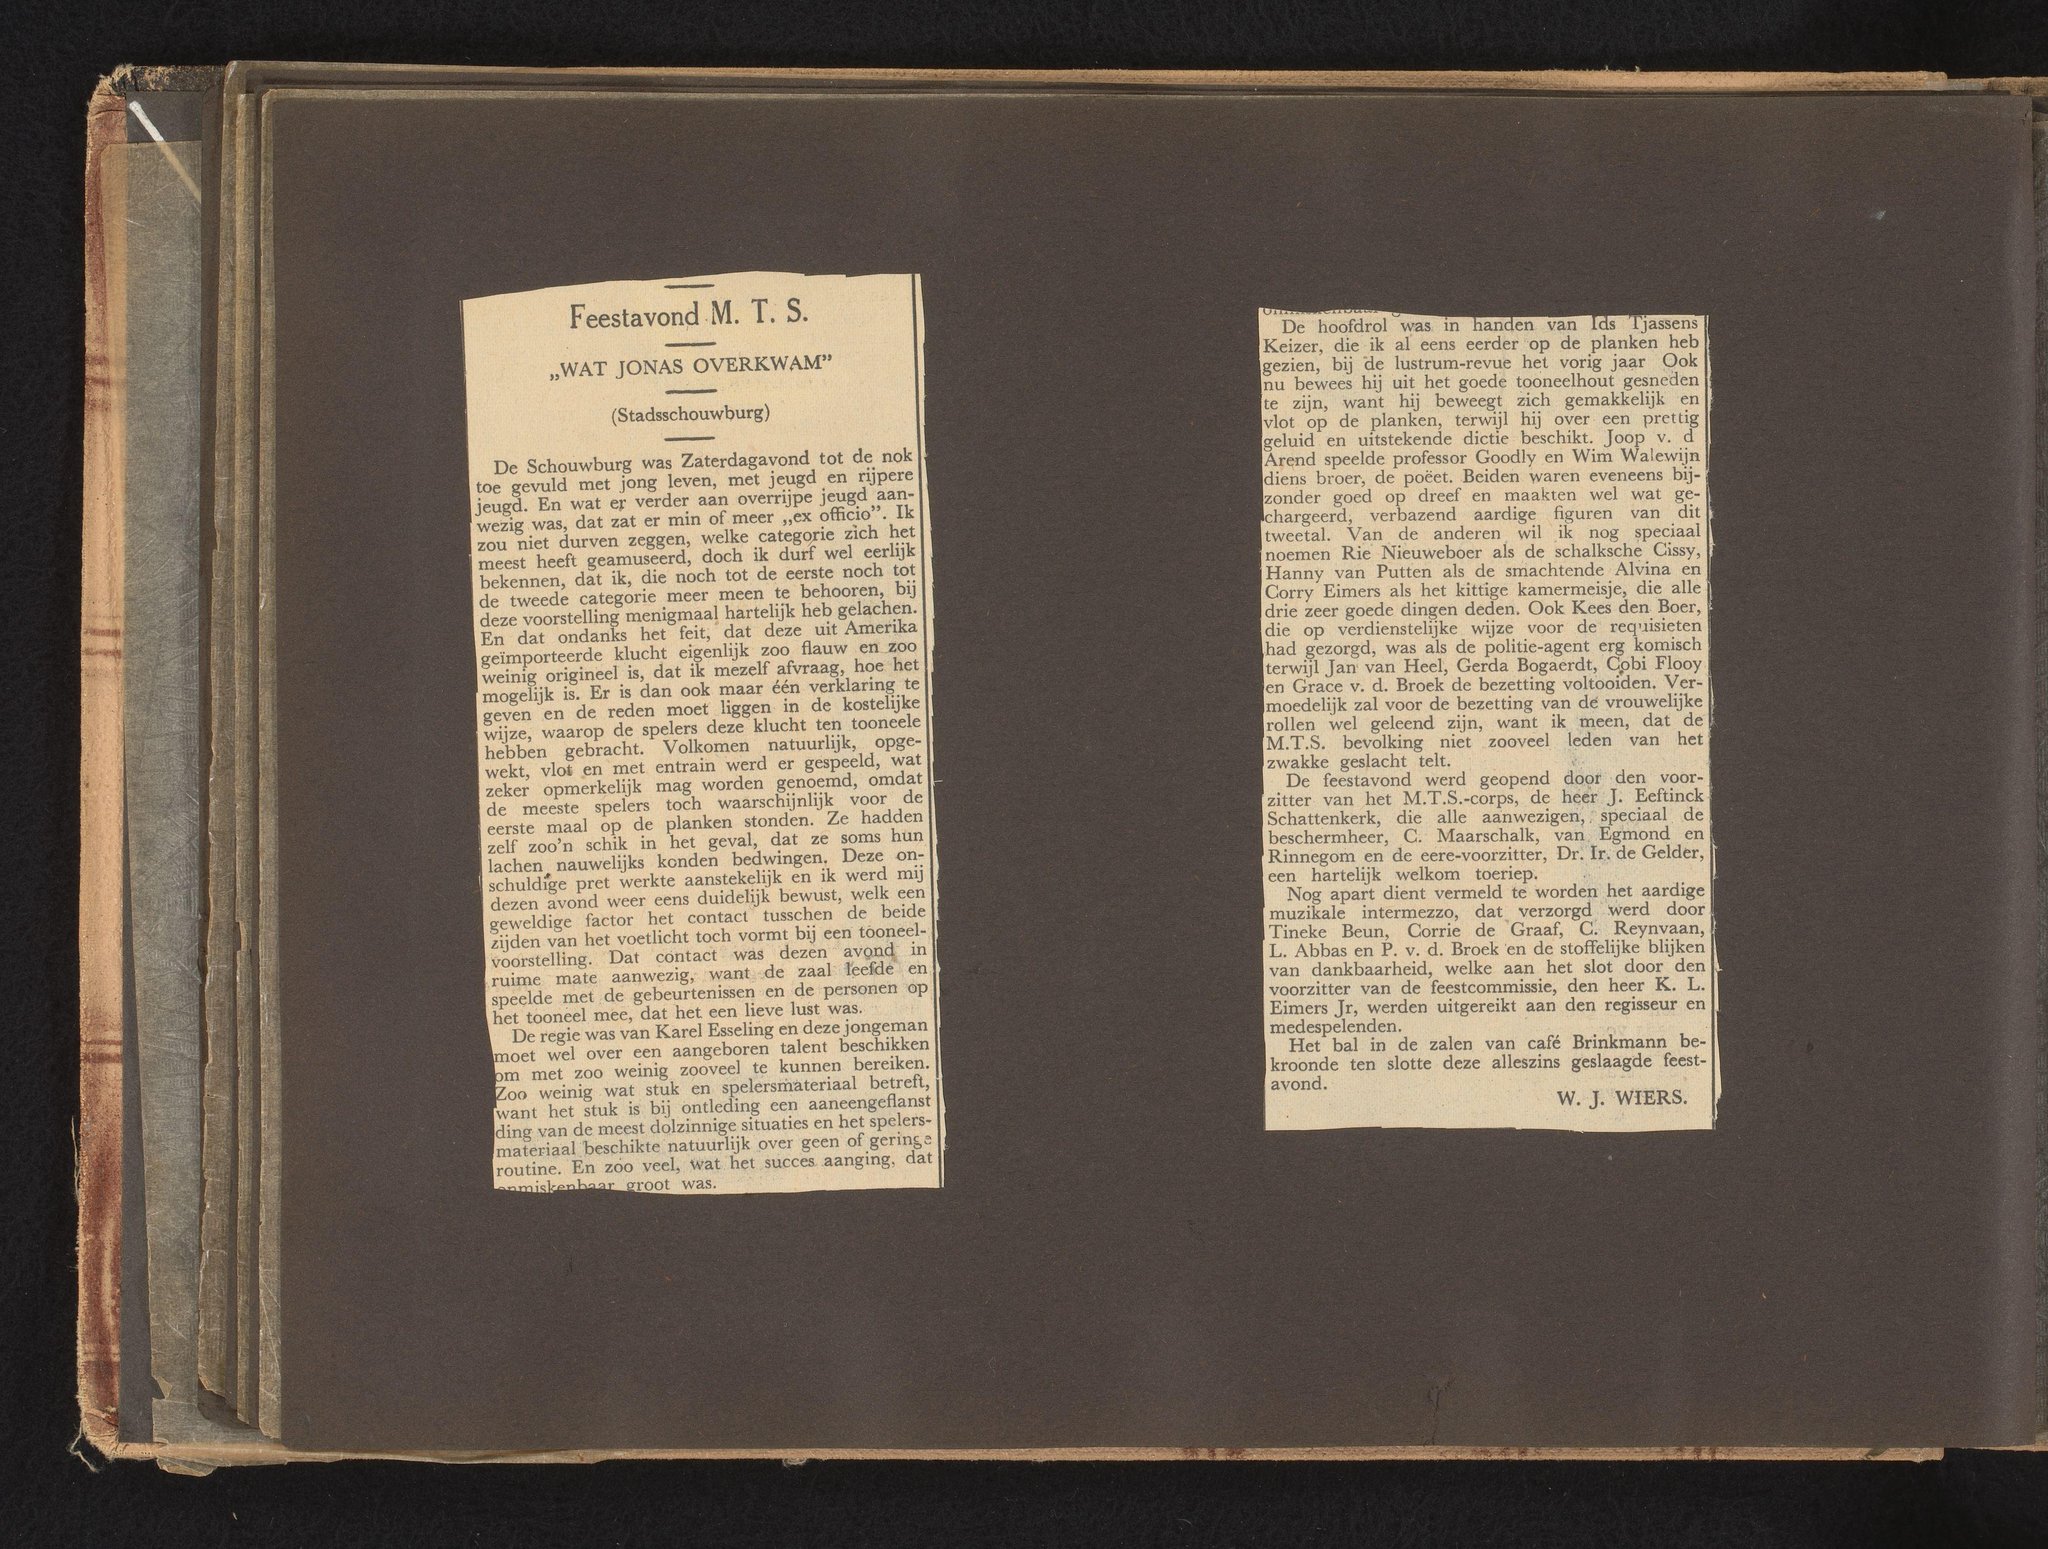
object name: newspaper clipping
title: Recensie van het toneelstuk van het Corps van leerlingen van de MTS te Haarlem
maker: Anonymous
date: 1936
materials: paper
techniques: printed materials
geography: haarlem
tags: students' organization, vocational education, e.g.: junior technical school, haarlem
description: Albumblad met een krantenknipsel in twee kolommen met een recensie van het toneelstuk opgevoerd op de feestavond van het Corps van leerlingen van de MTS te Haarlem op 22 februari, 1936. Onderdeel van het fotoalbum 'Jaarfeesten van het Corps M.T.S. te Haarlem'.